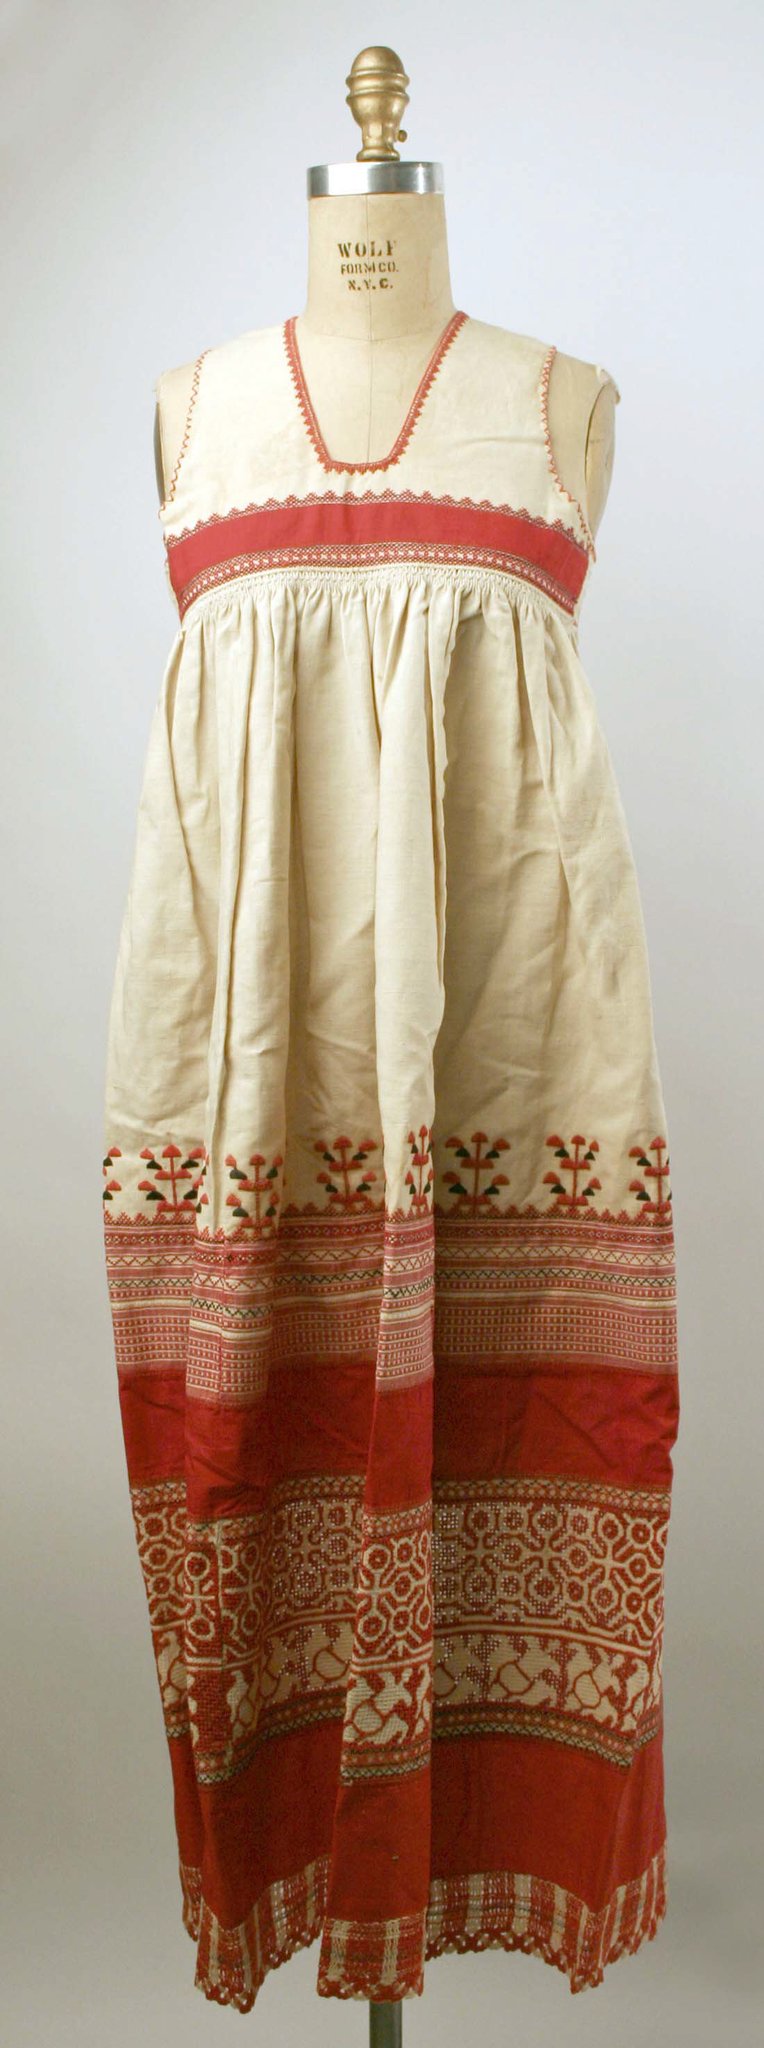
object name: apron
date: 1801-1900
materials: cotton, linen